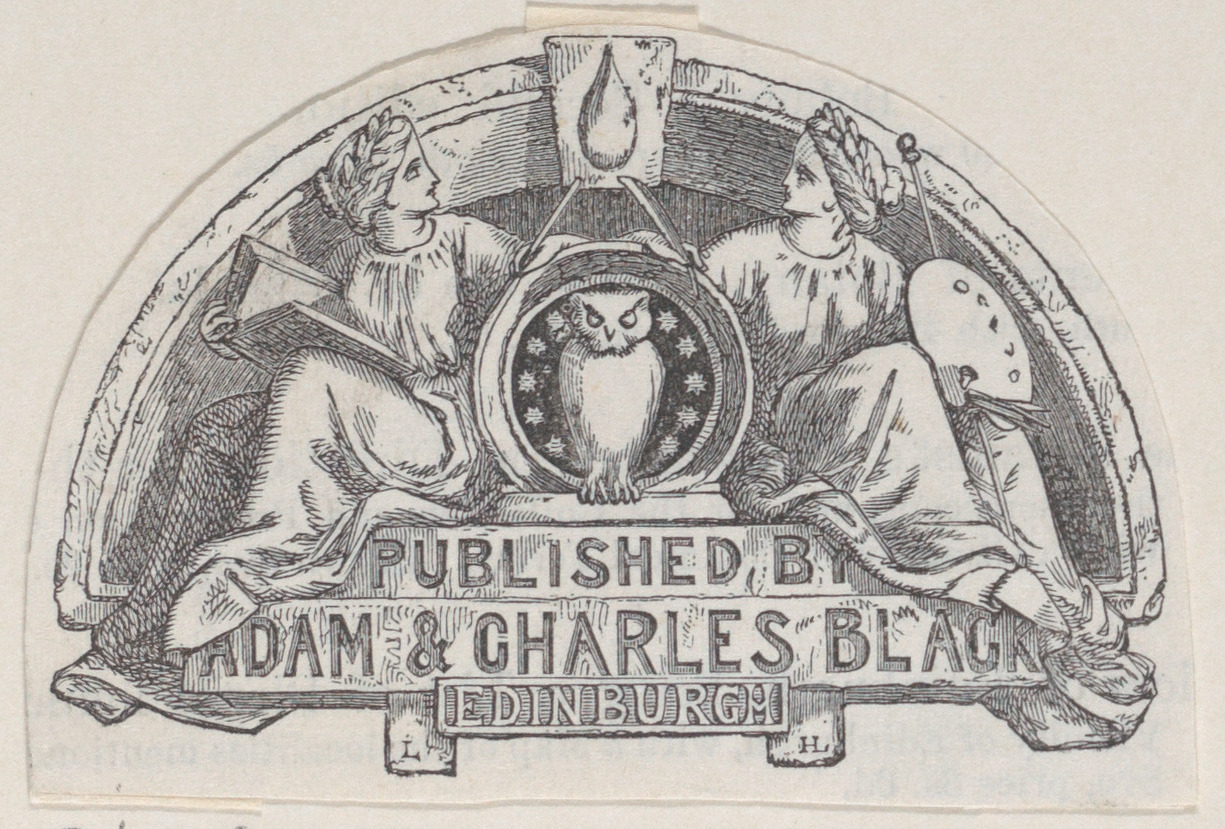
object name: print, trade card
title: Trade Card for Adam & Charles Black, Publishers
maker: anonymous, british, 19th century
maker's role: artist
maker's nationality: british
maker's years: 1800-1900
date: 1801-1900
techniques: engraving